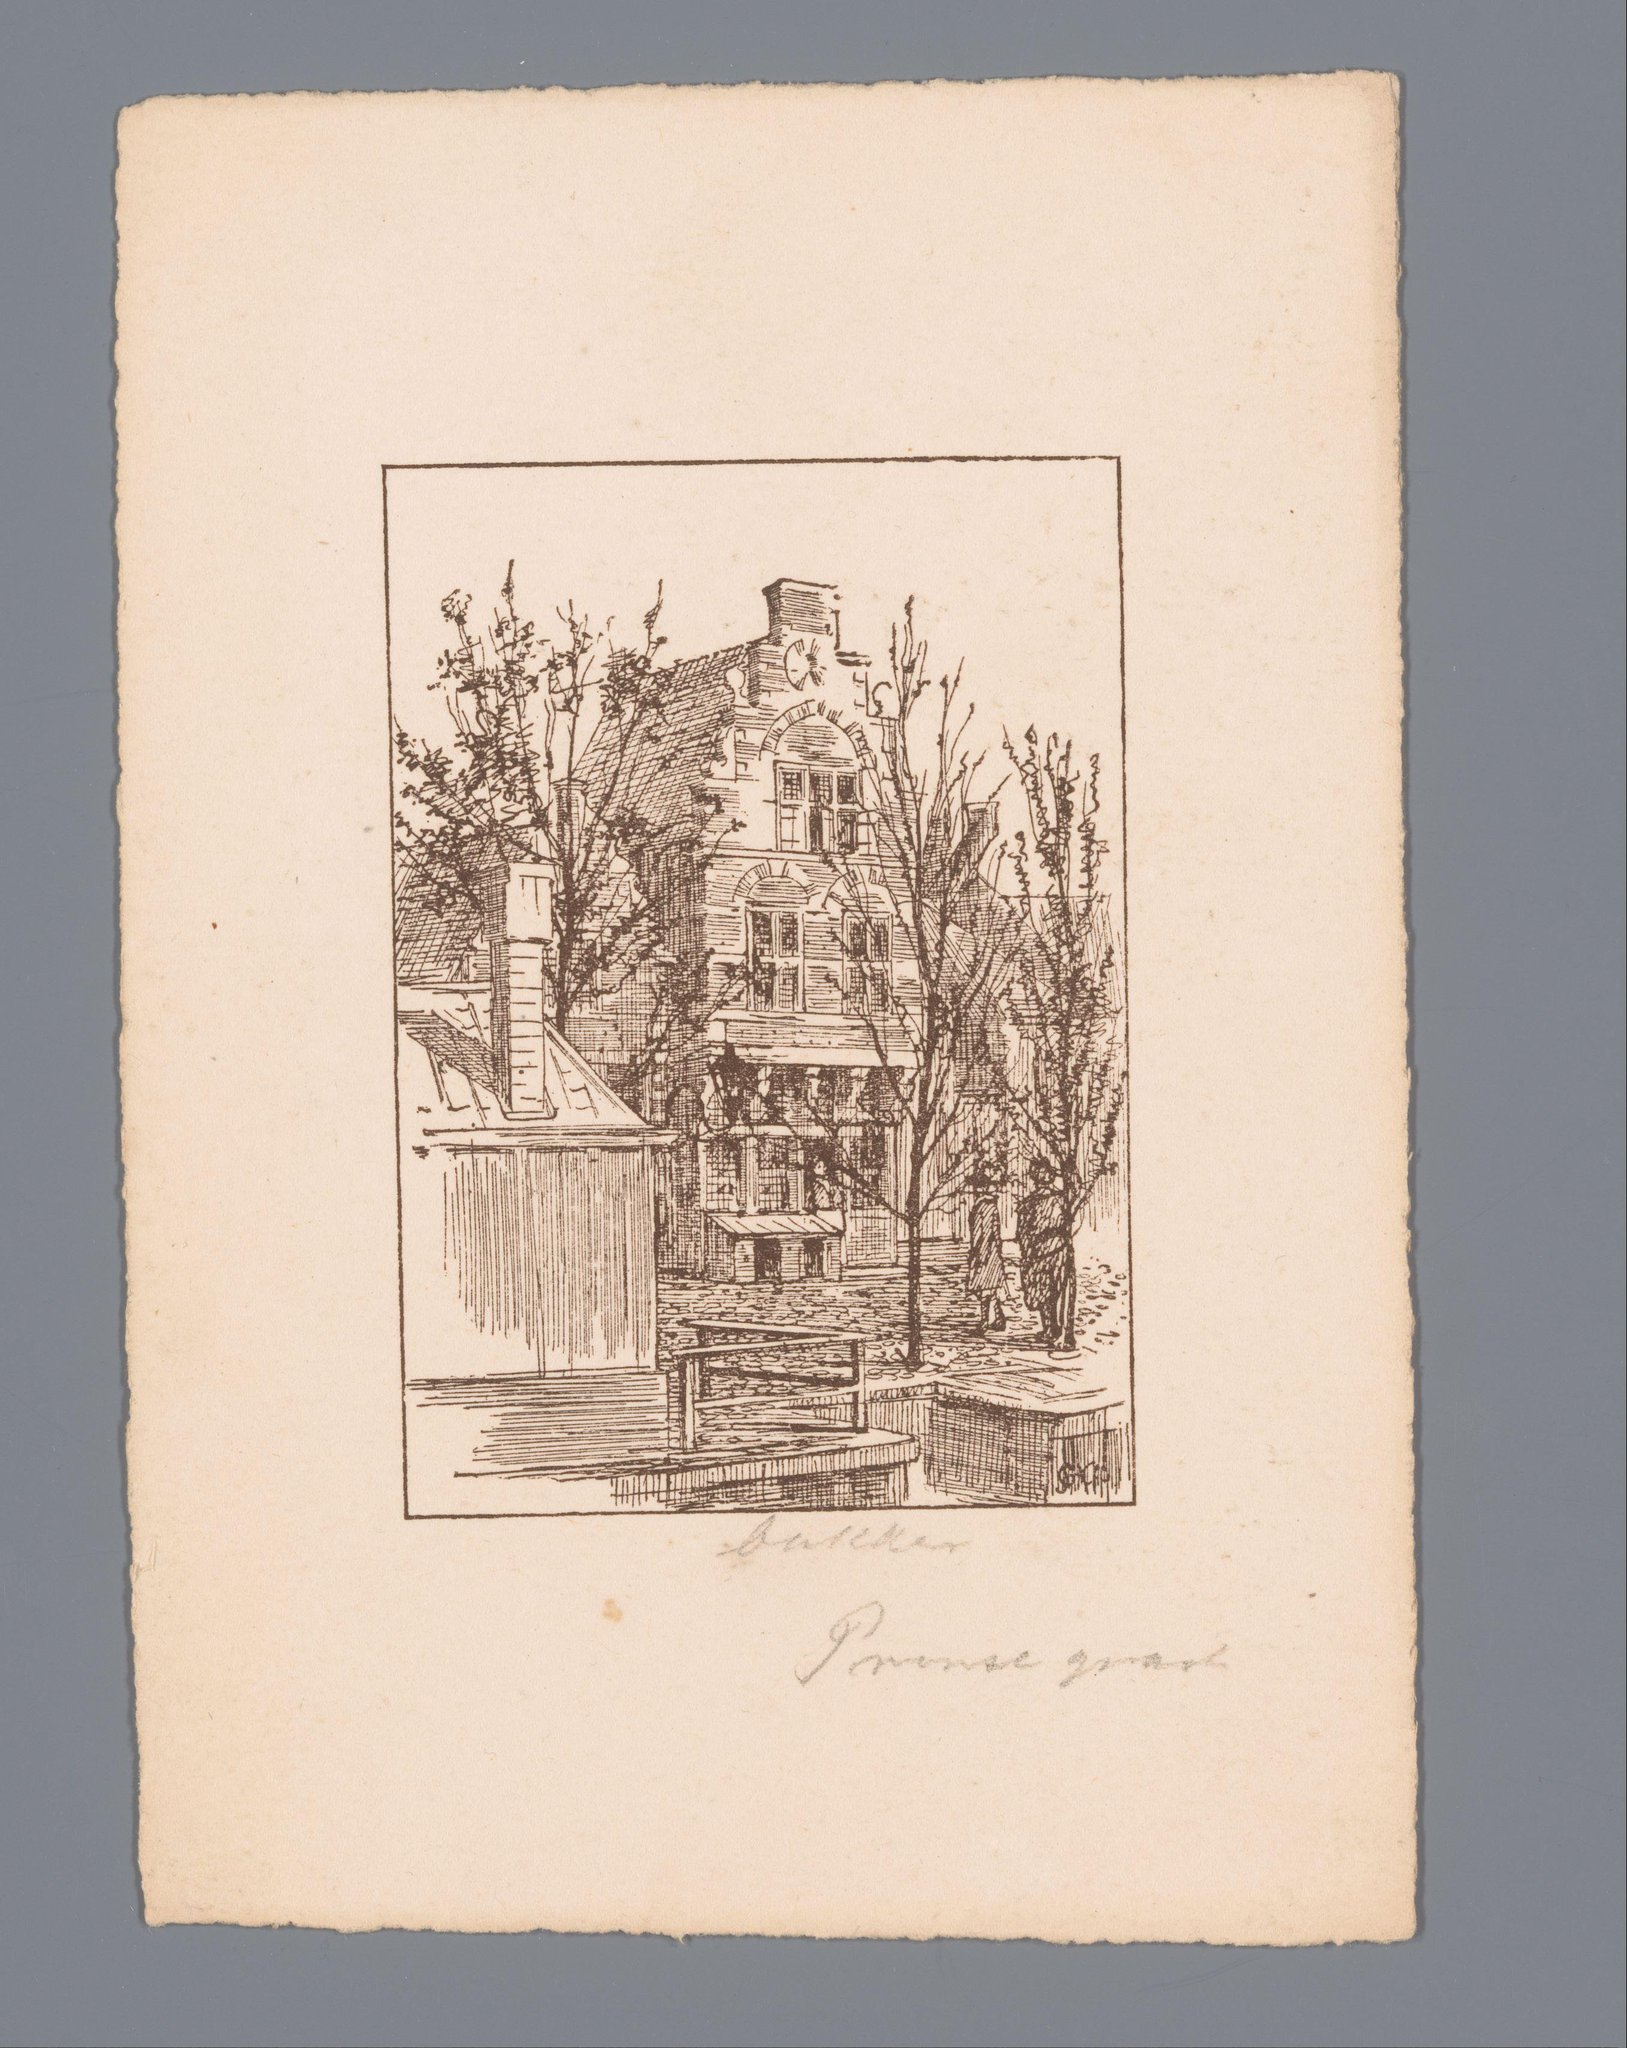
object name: print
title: Gezicht op een Amsterdamse trapgevel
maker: Anonymous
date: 1800-1899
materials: paper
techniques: lithograph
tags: civic architecture; edifices; dwellings, amsterdam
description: Rechtsonder gemonogrammeerd JCKH of CJKH.